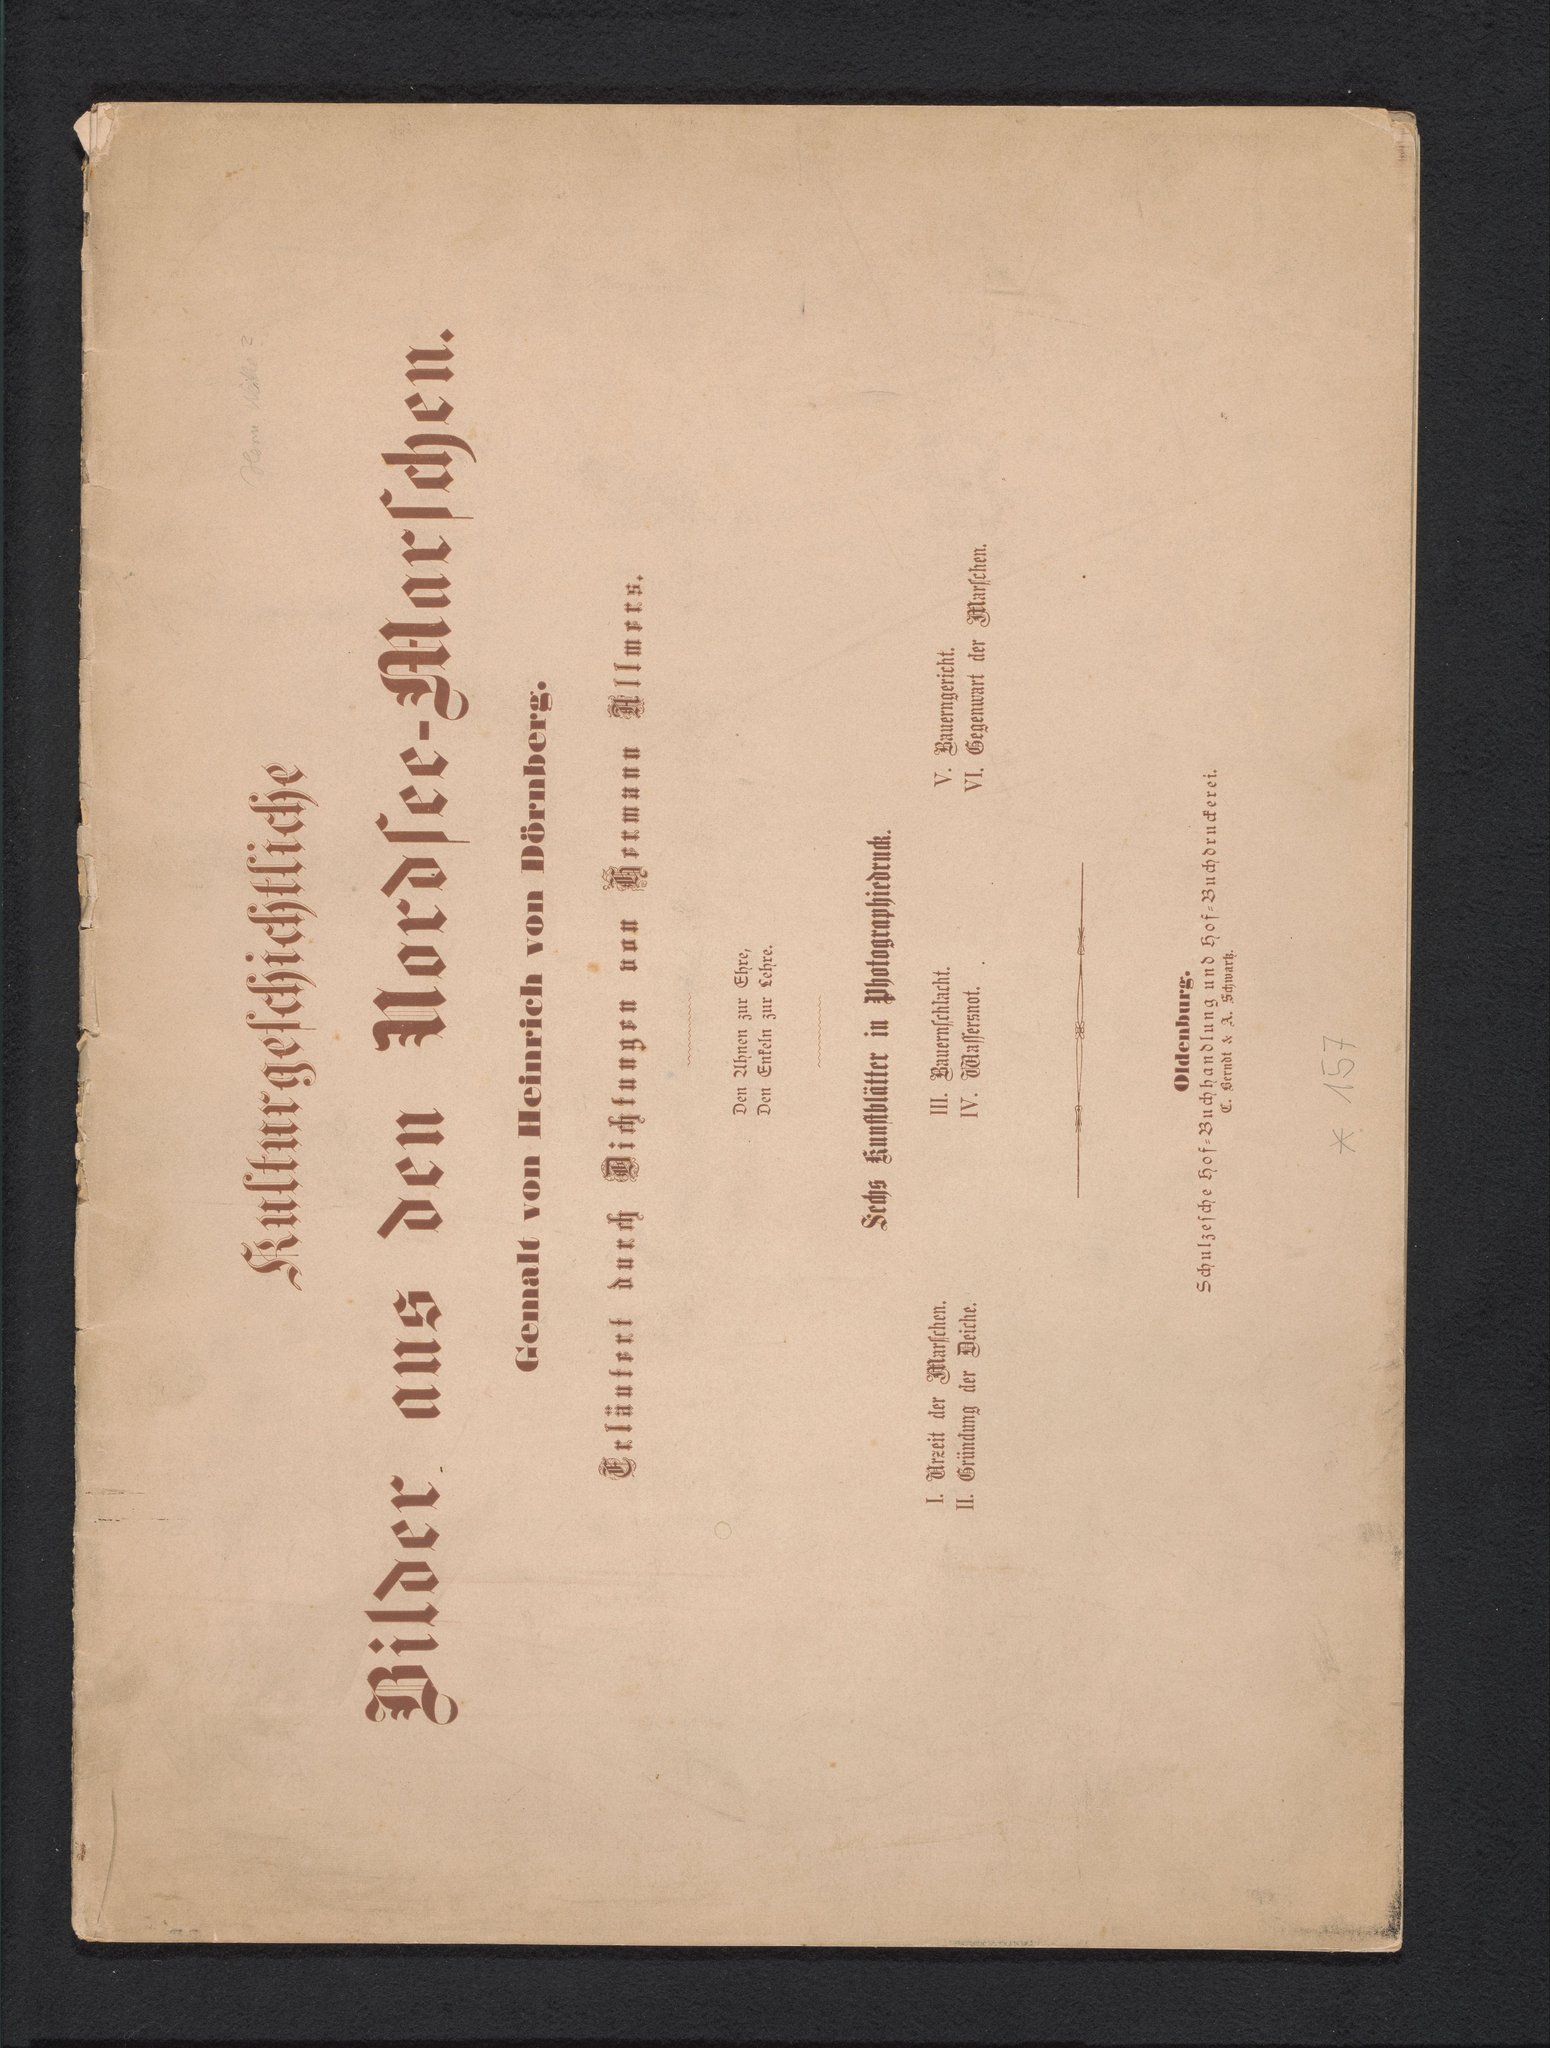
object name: wrapper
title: Kulturgeschichtliche Bilder aus den Nordsee-Marschen / gemalt von Heinrich von Dörnberg; erl. durch Dichtungen von Hermann Allmers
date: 1881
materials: cardboard, paper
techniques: photograph, printing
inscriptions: date: ‘OCT/ 1996’, number: ‘*157’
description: Omslag met zes prenten en een tekstblad.